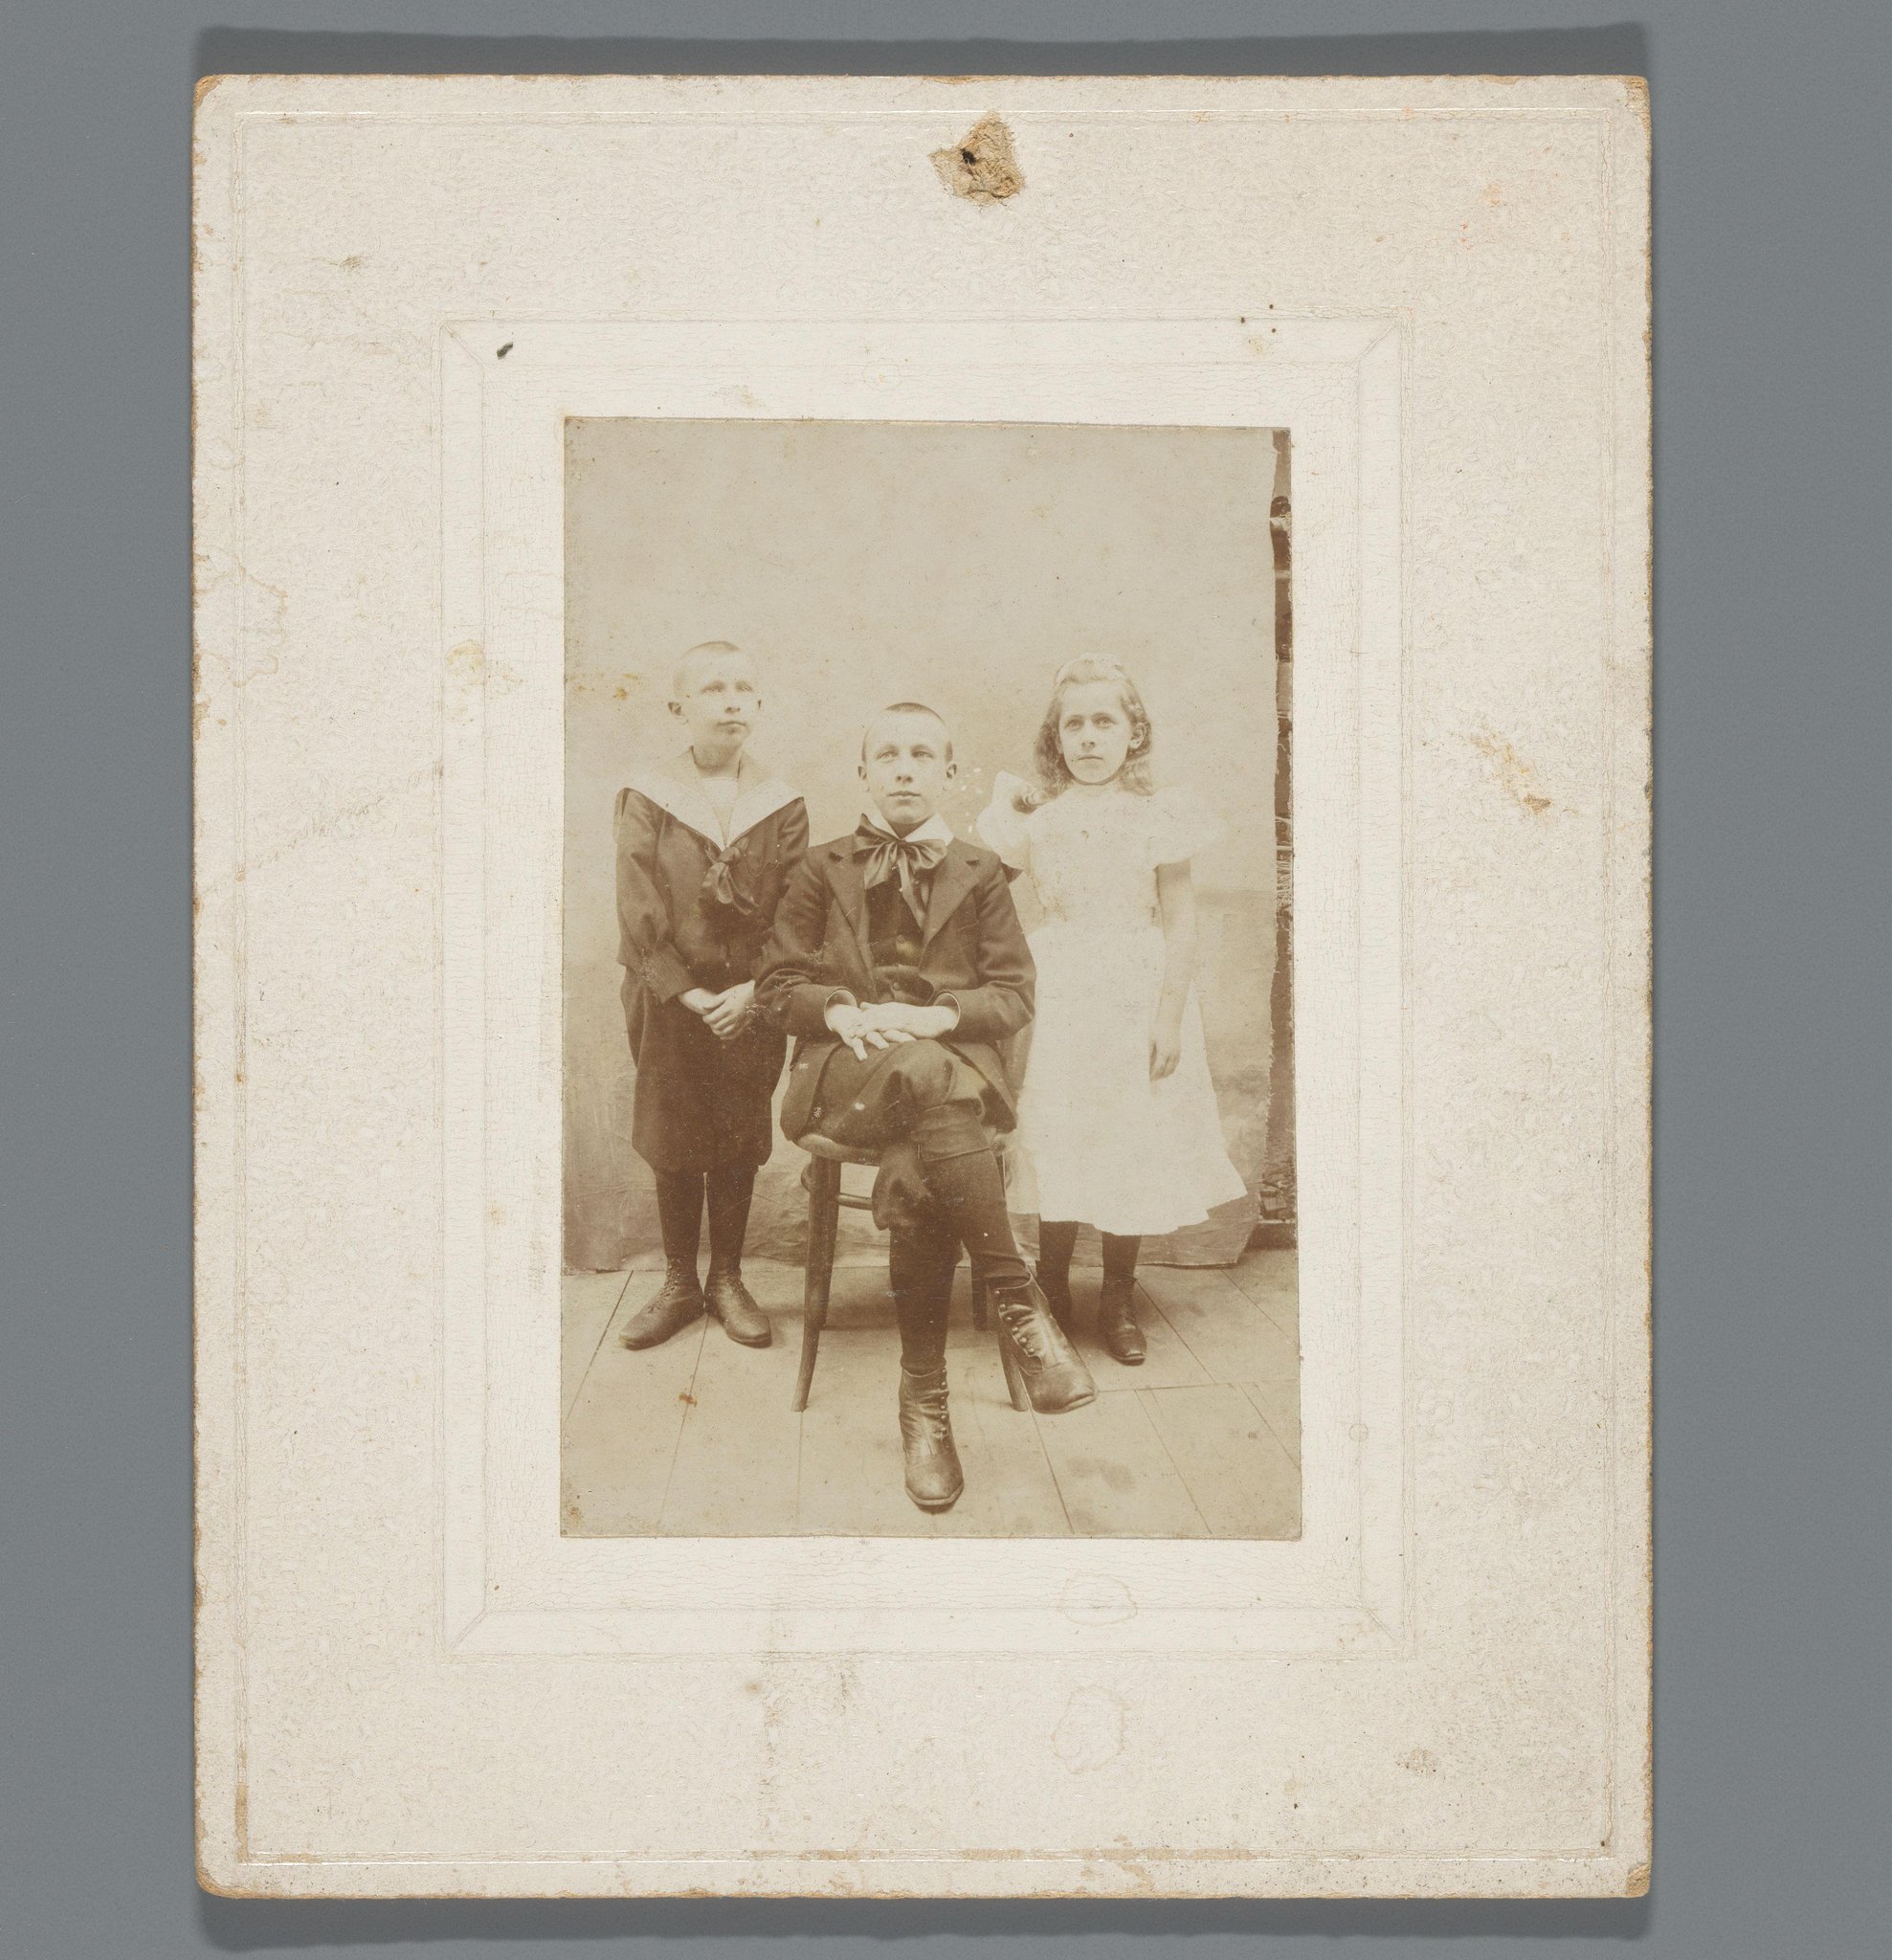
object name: photograph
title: Groepsportret van drie onbekende kinderen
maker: Anonymous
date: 1890-1930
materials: paper, cardboard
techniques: gelatin silver print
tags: child, anonymous historical persons portrayed in a group, in a group-portrait